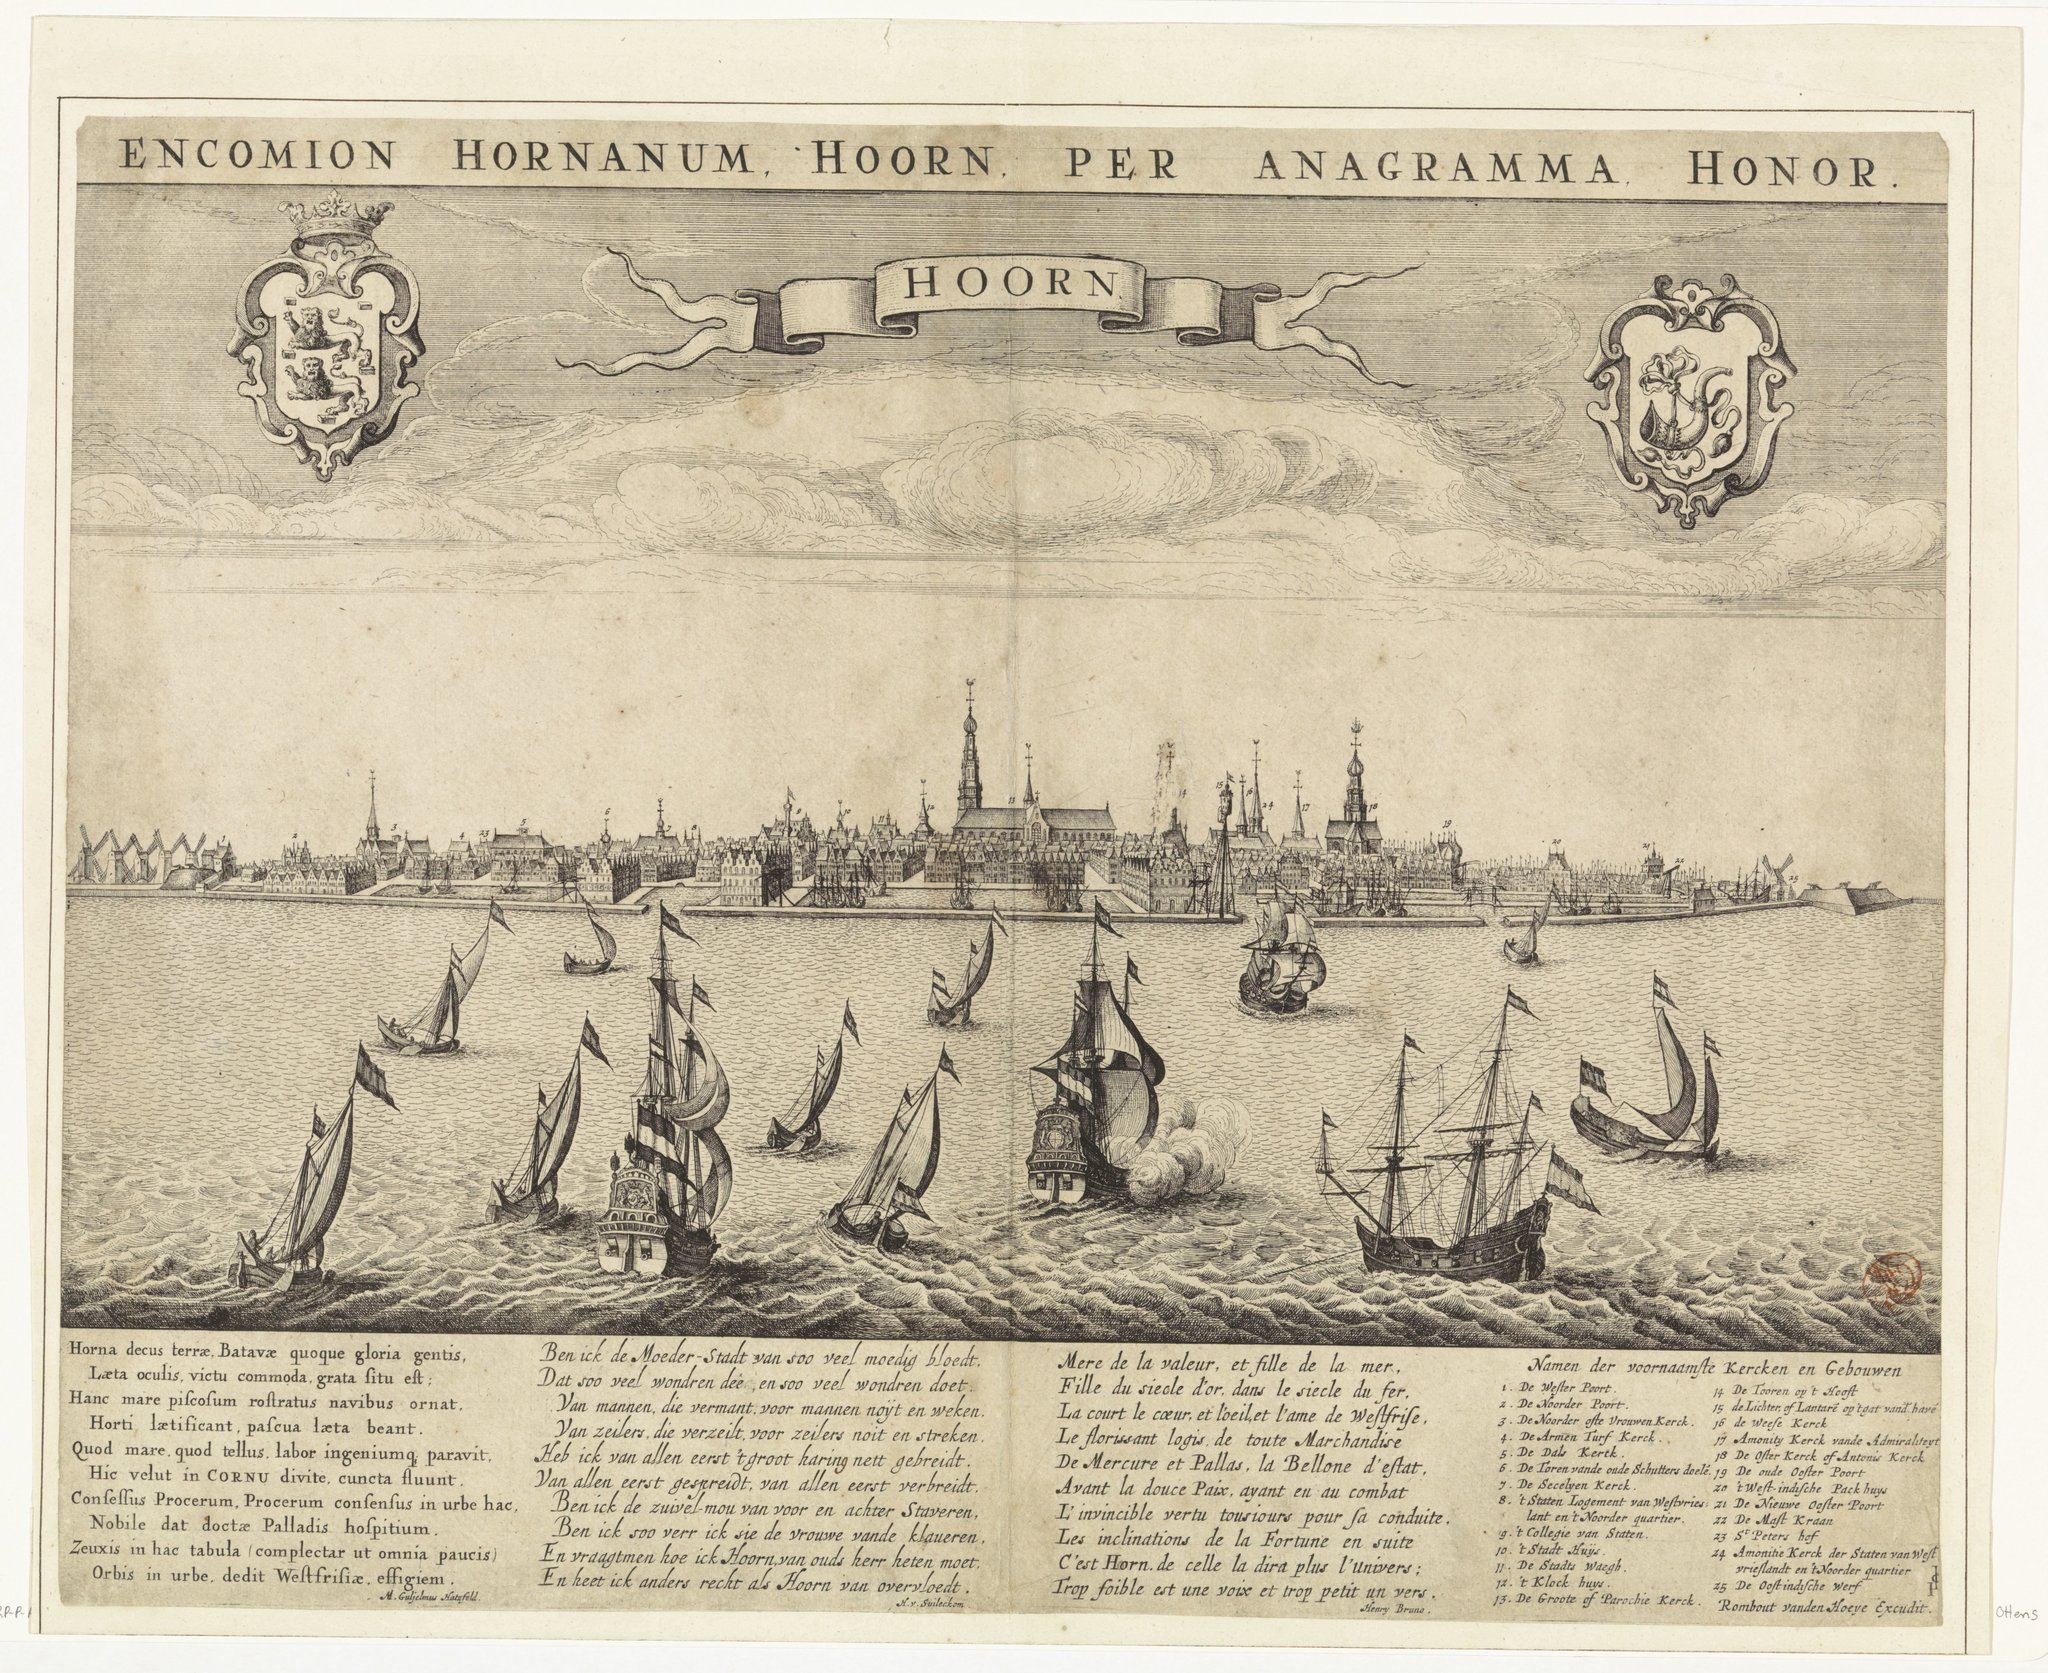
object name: print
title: Hoorn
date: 1654-1657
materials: paper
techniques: etching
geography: amsterdam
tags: harbour, sailing-ship, sailing-boat, hoorn (north holland)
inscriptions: collector's mark: Lugt 195, collector's mark: Lugt 2228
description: Zicht op Hoorn vanaf een druk bevaren zee. Onder het stadsgezicht drie lofprijzingen op Hoorn en een legenda. Boven de wolkenpartij de wapens van Hoorn en Westfriesland. Met opschrift 'Encomium Hornarum, Hoorn, per anagramma, Honor'.